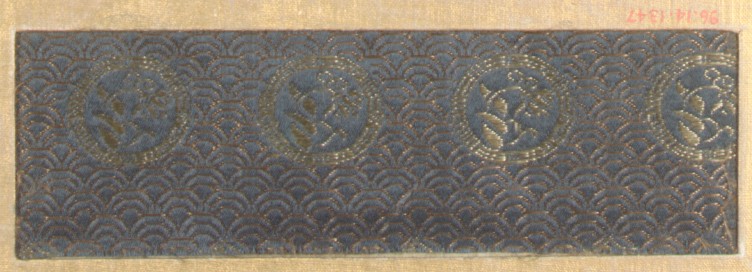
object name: piece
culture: japanese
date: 1701-1900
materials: silk